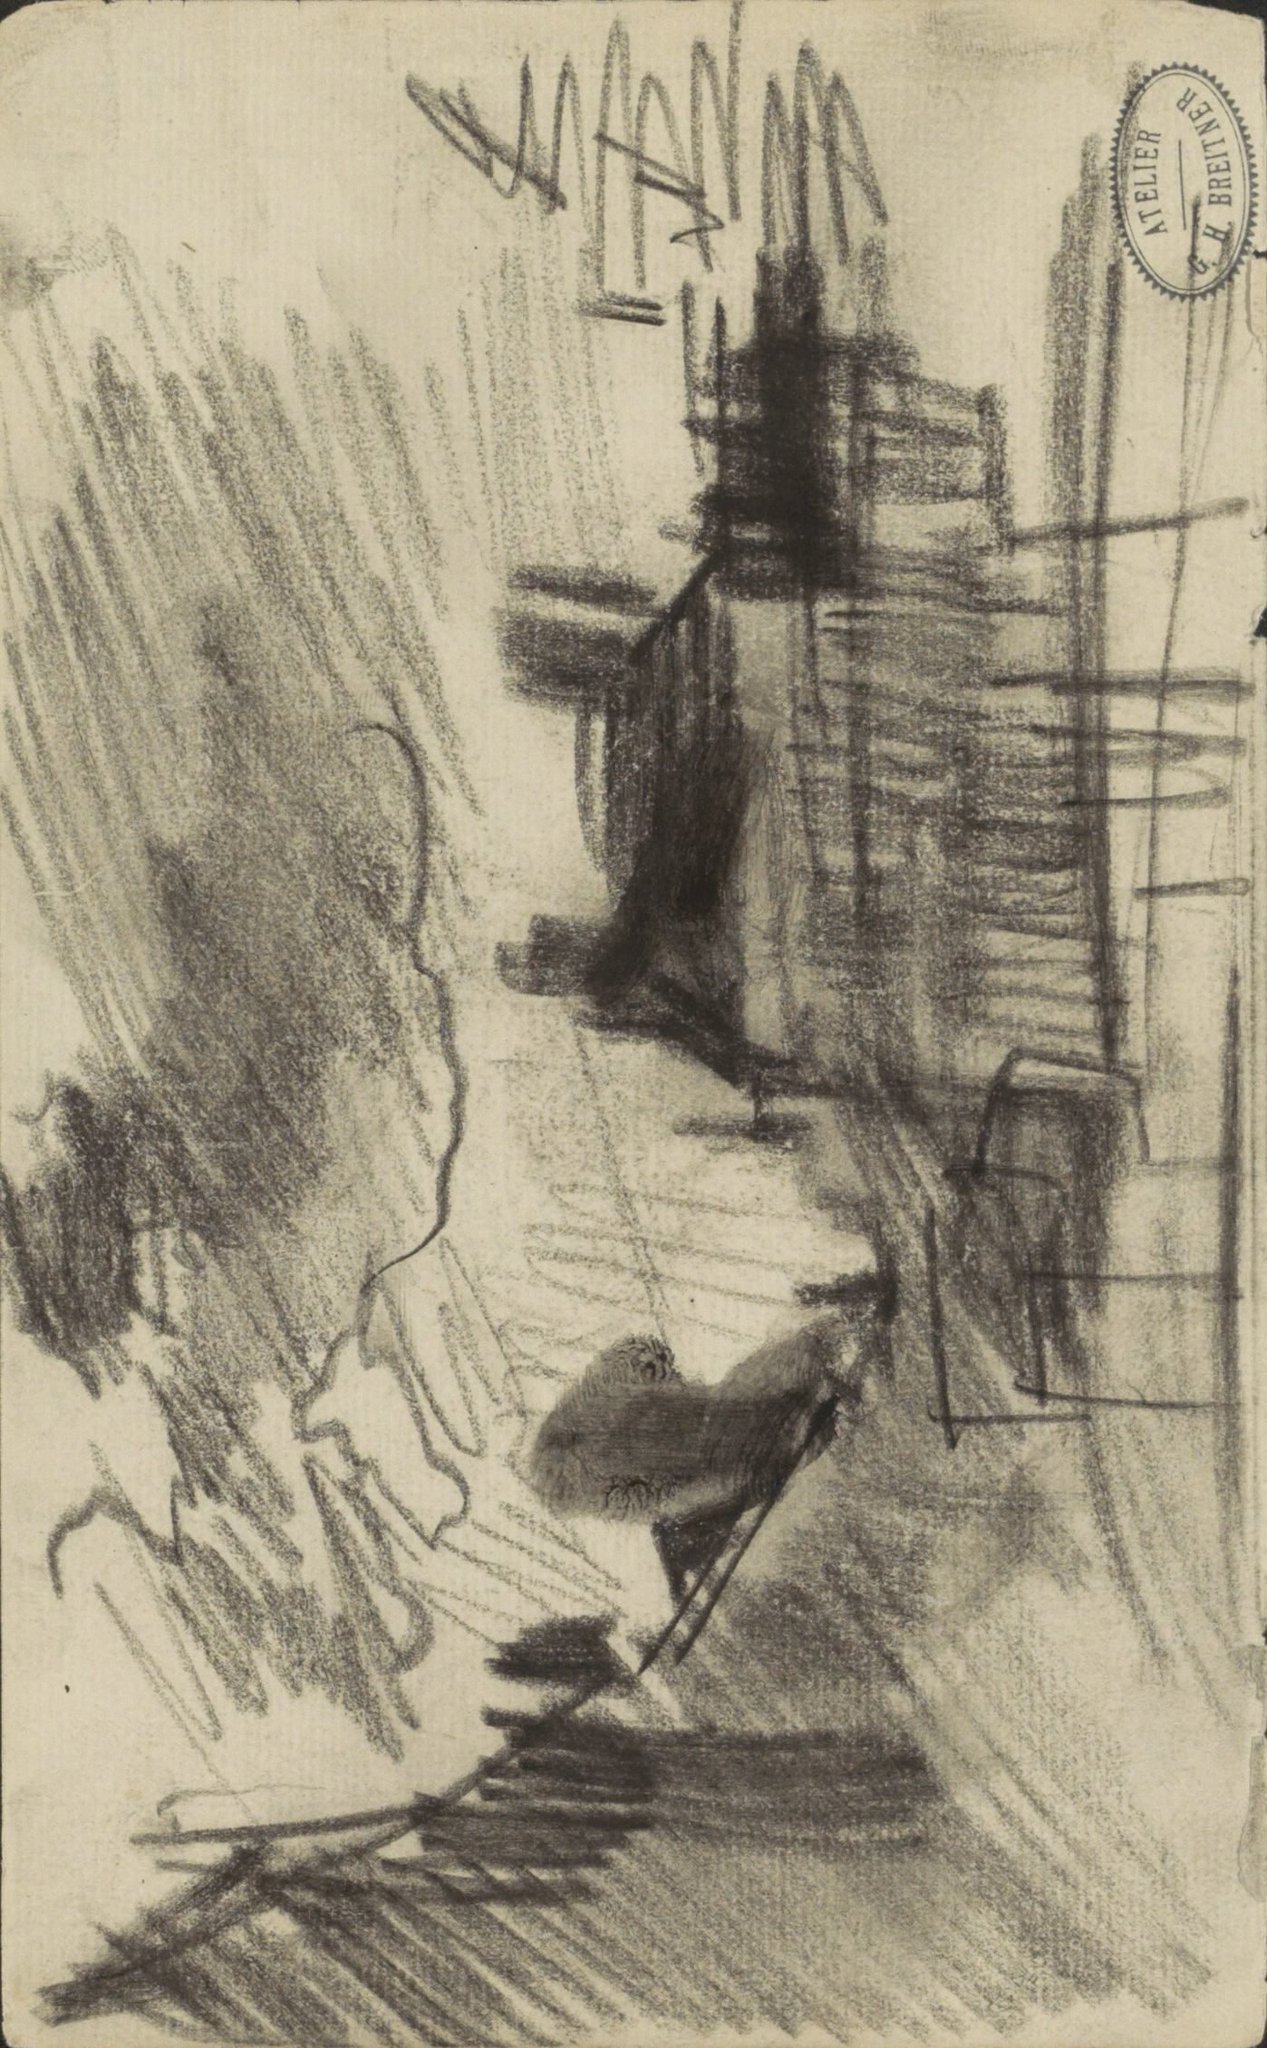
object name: drawing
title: Stadsgezicht, mogelijk in Amsterdam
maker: george hendrik breitner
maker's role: draughtsman, painter, print maker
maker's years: 1857-1923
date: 1886-1923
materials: chalk, paper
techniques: stumping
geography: amsterdam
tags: city-view, and landscape with man-made constructions, amsterdam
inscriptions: workshop stamp: Lugt 291d